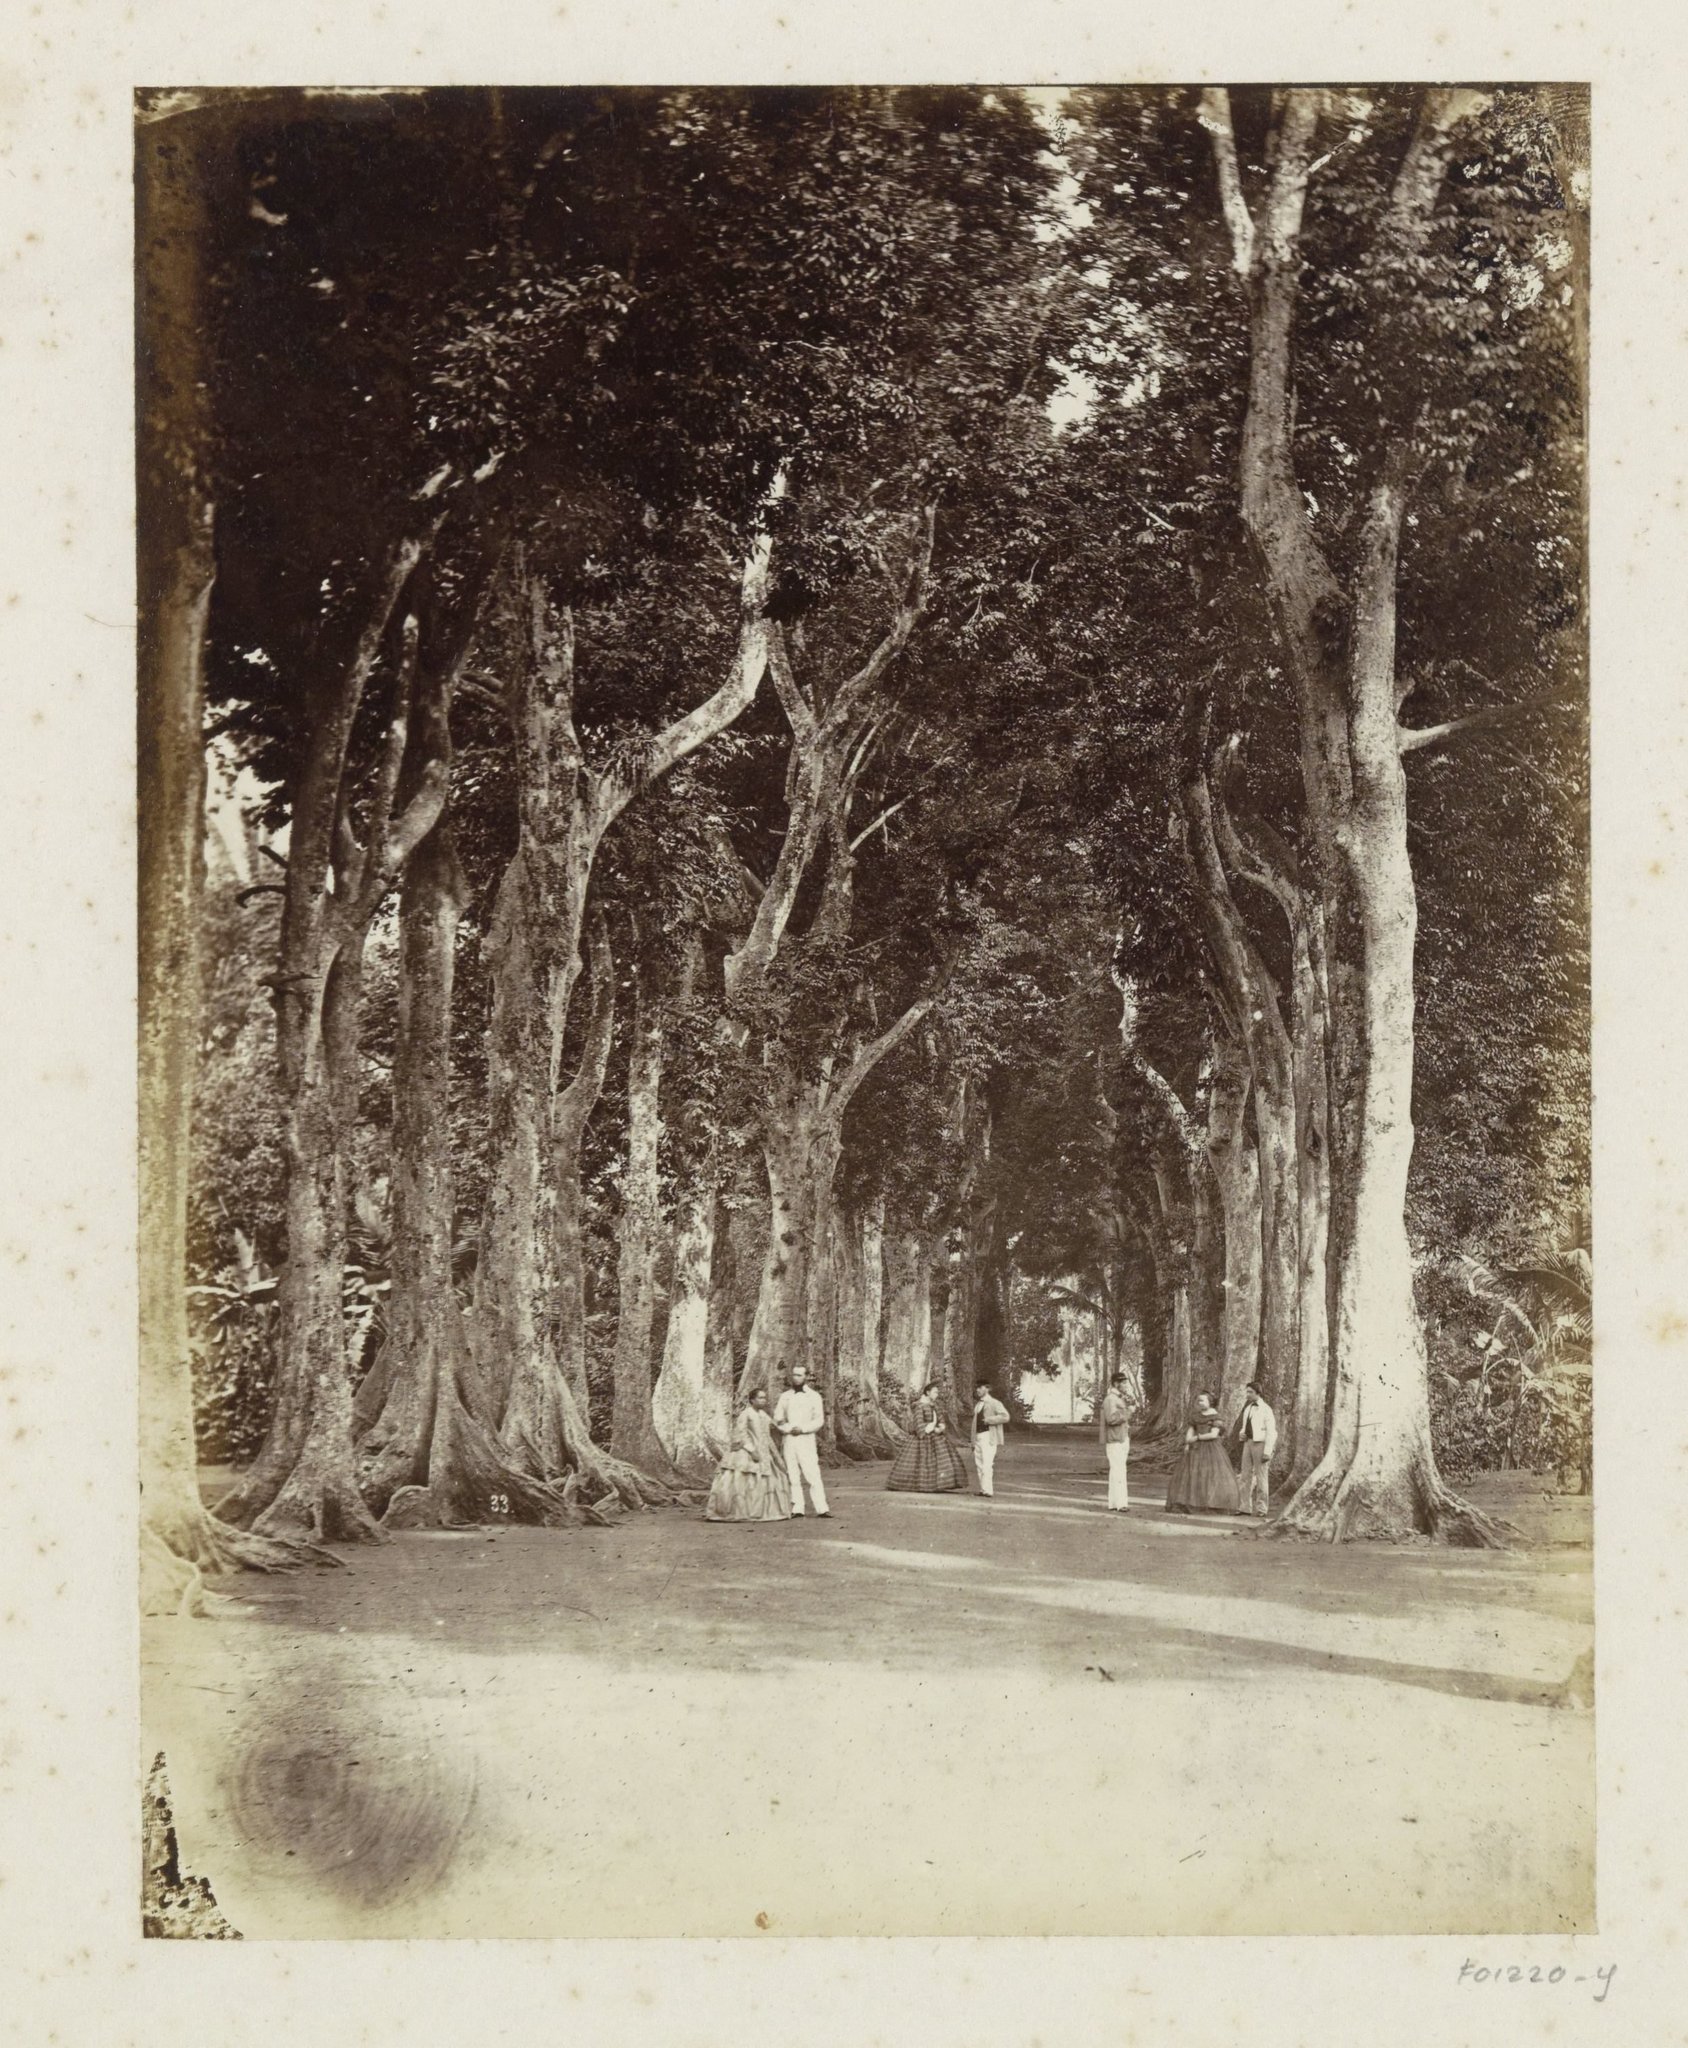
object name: photograph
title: Gezelschap op de Kenarielaan in Batavia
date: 1857-1870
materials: photographic support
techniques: albumen print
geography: batavia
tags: forest path or lane, batavia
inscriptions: number: ‘33’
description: Onderdeel van Fotoalbum met opnames van bezienswaardigheden op Java.